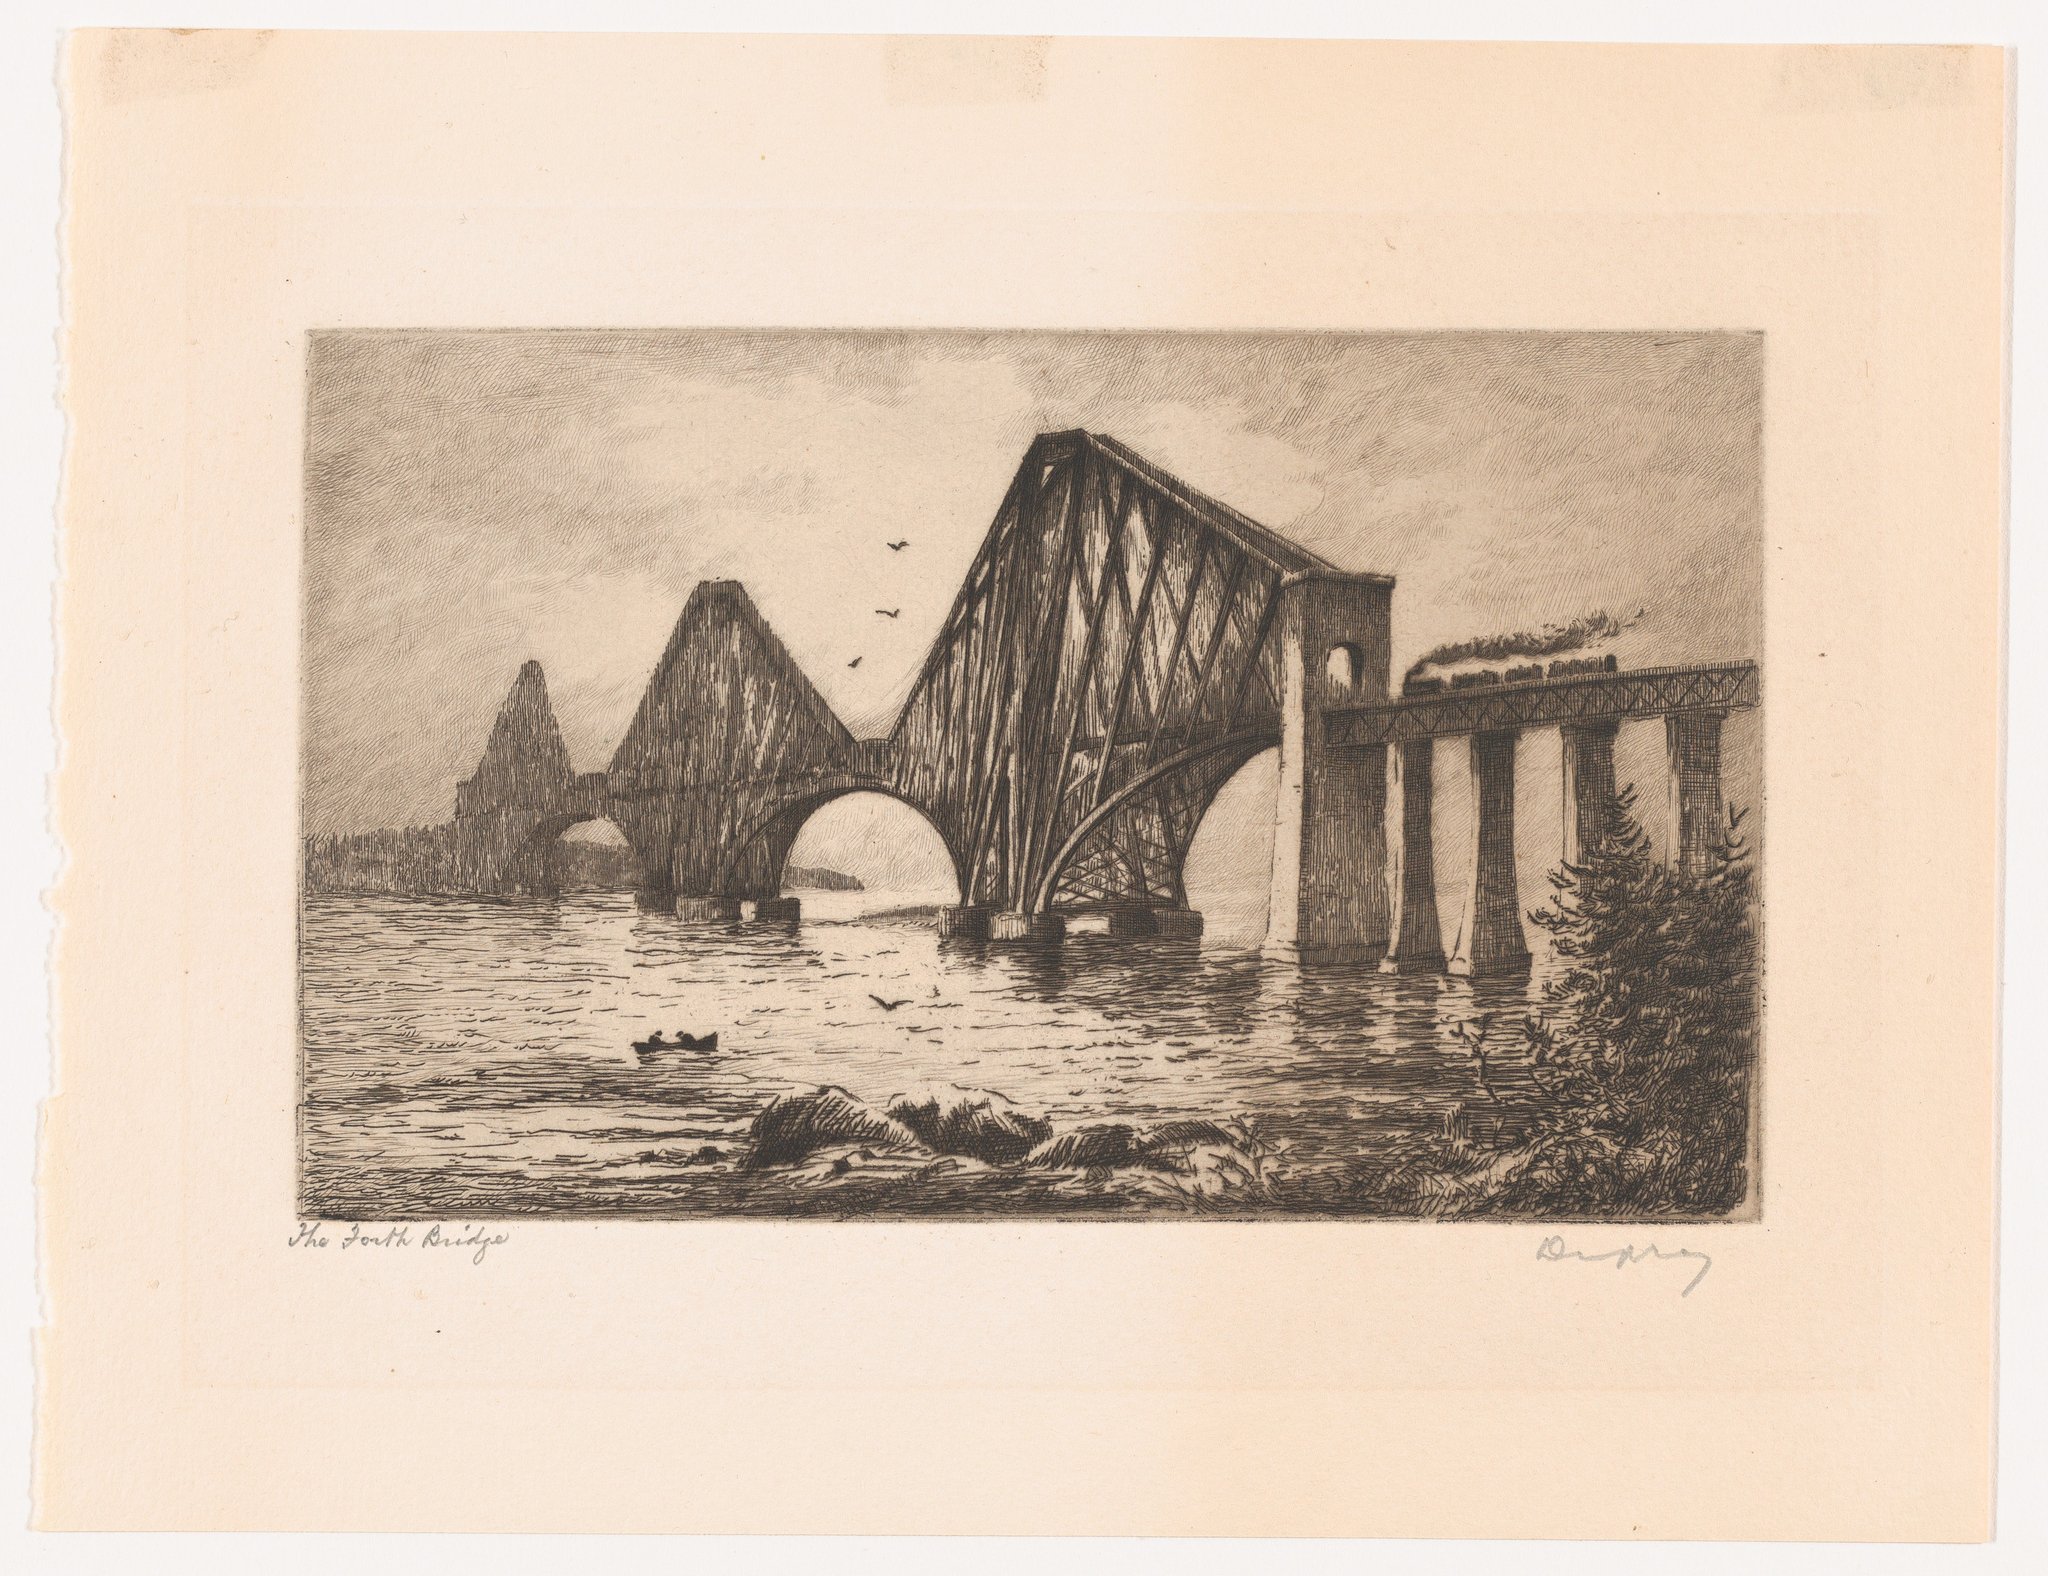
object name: print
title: The Forth Bridge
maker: a. duprez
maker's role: artist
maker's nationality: british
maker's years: 1850-1950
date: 1890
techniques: etching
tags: bridges,canals